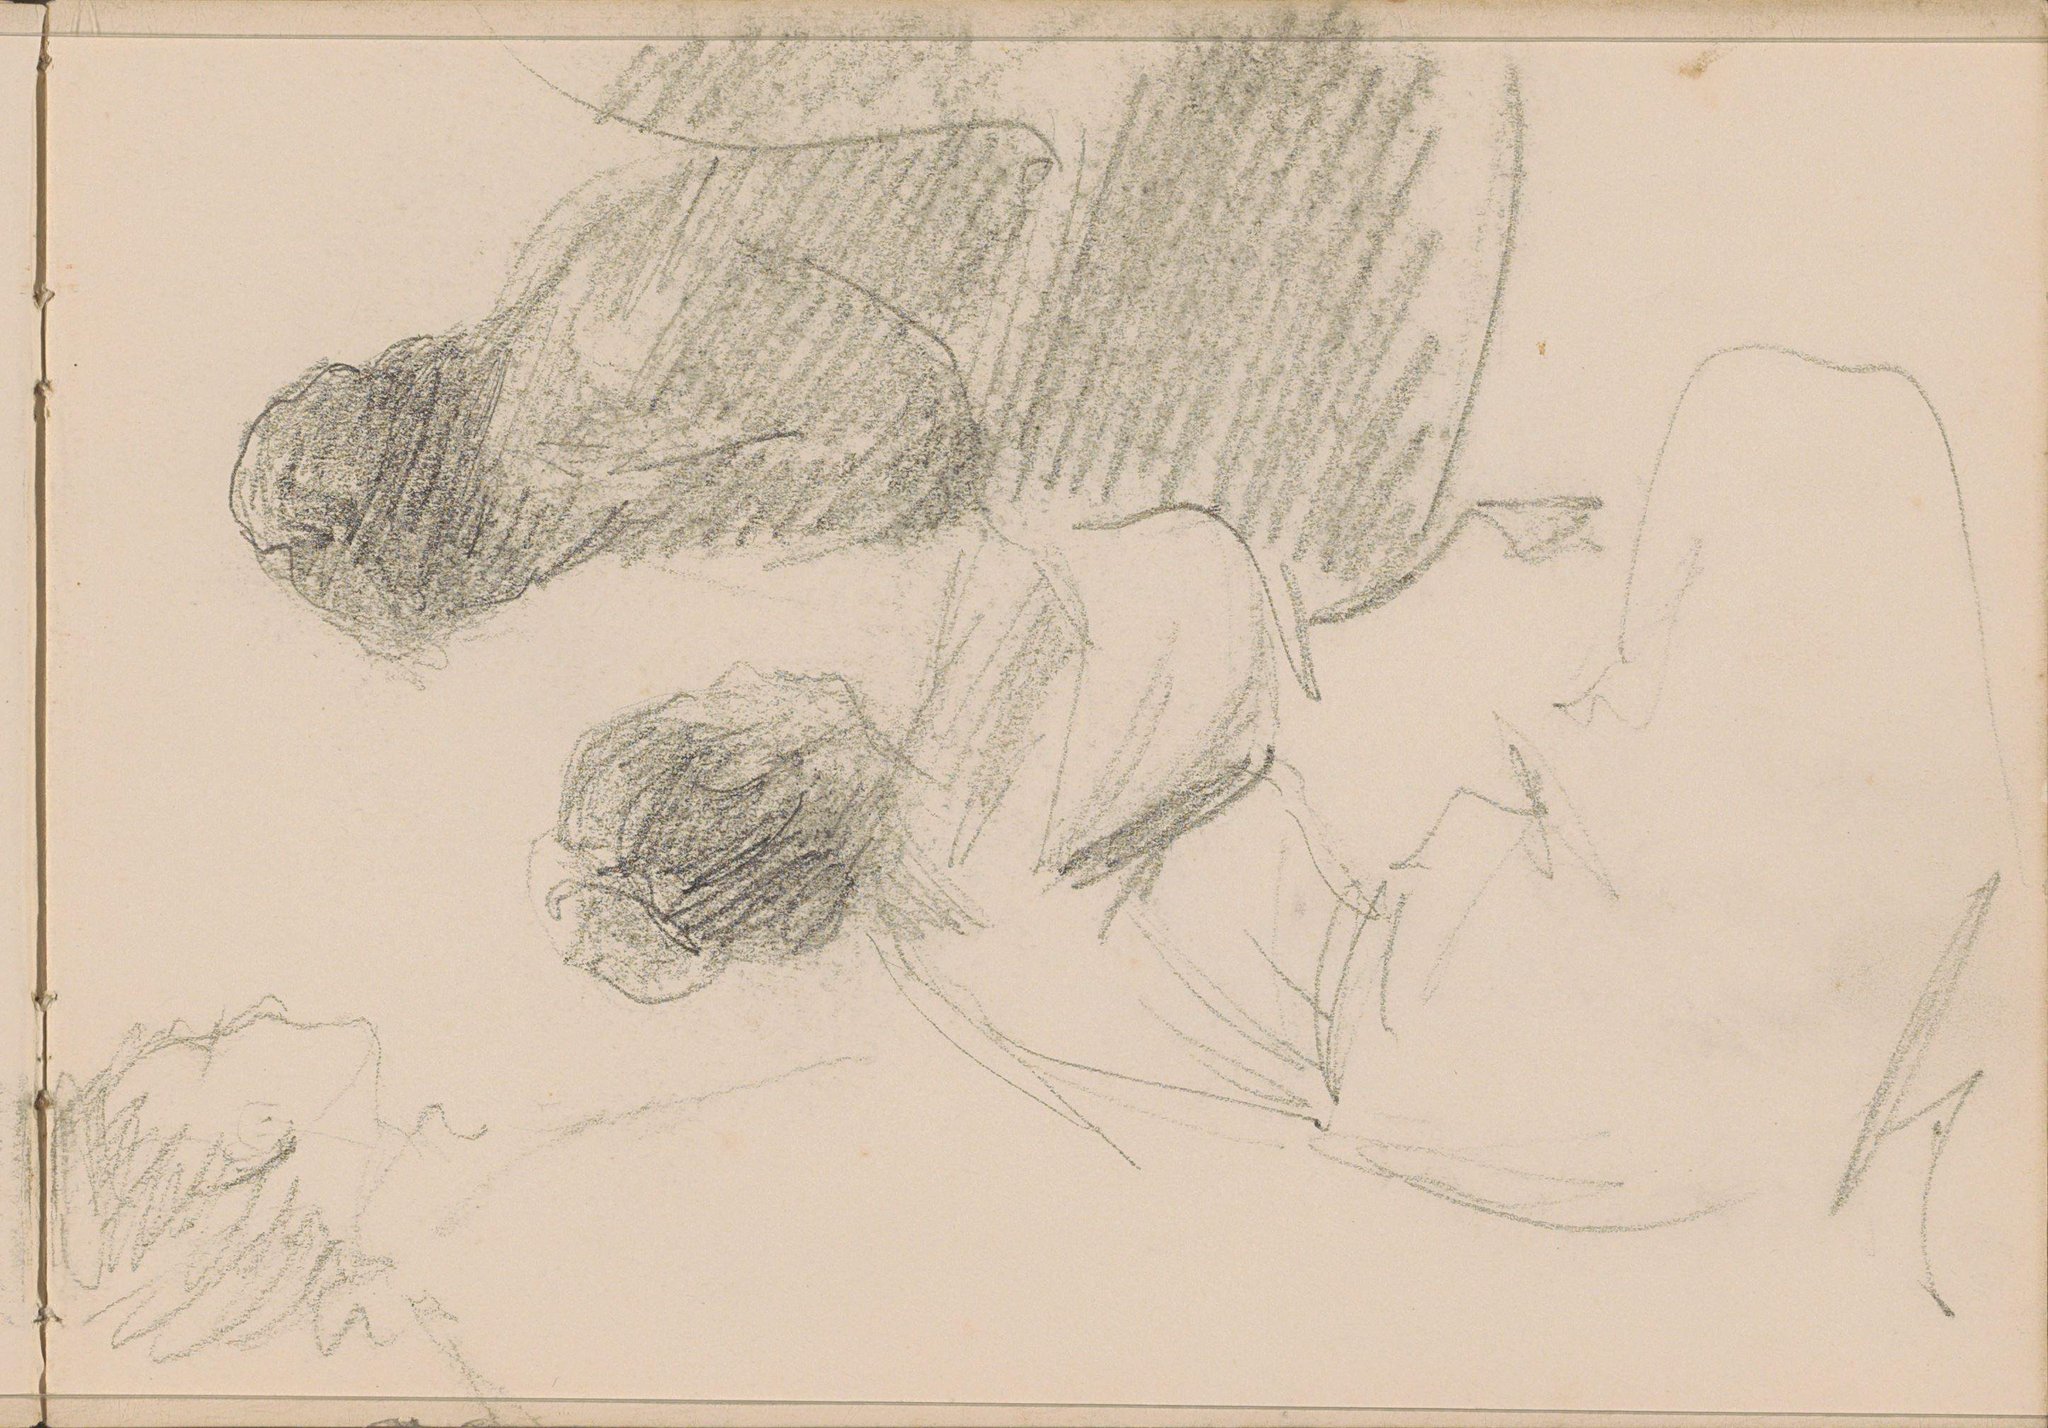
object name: sketchbook leaf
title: Twee vrouwen, één zittend bij de stoel van de ander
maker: a.a.l. de grammont-hubrecht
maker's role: draughtsman, painter, print maker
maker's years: 1855-1913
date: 1865-1913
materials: paper, pencil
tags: head (human), sitting figure, adult woman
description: Tevens een vrouwenkop. Blad 14 recto uit een schetsboek met 68 bladen.